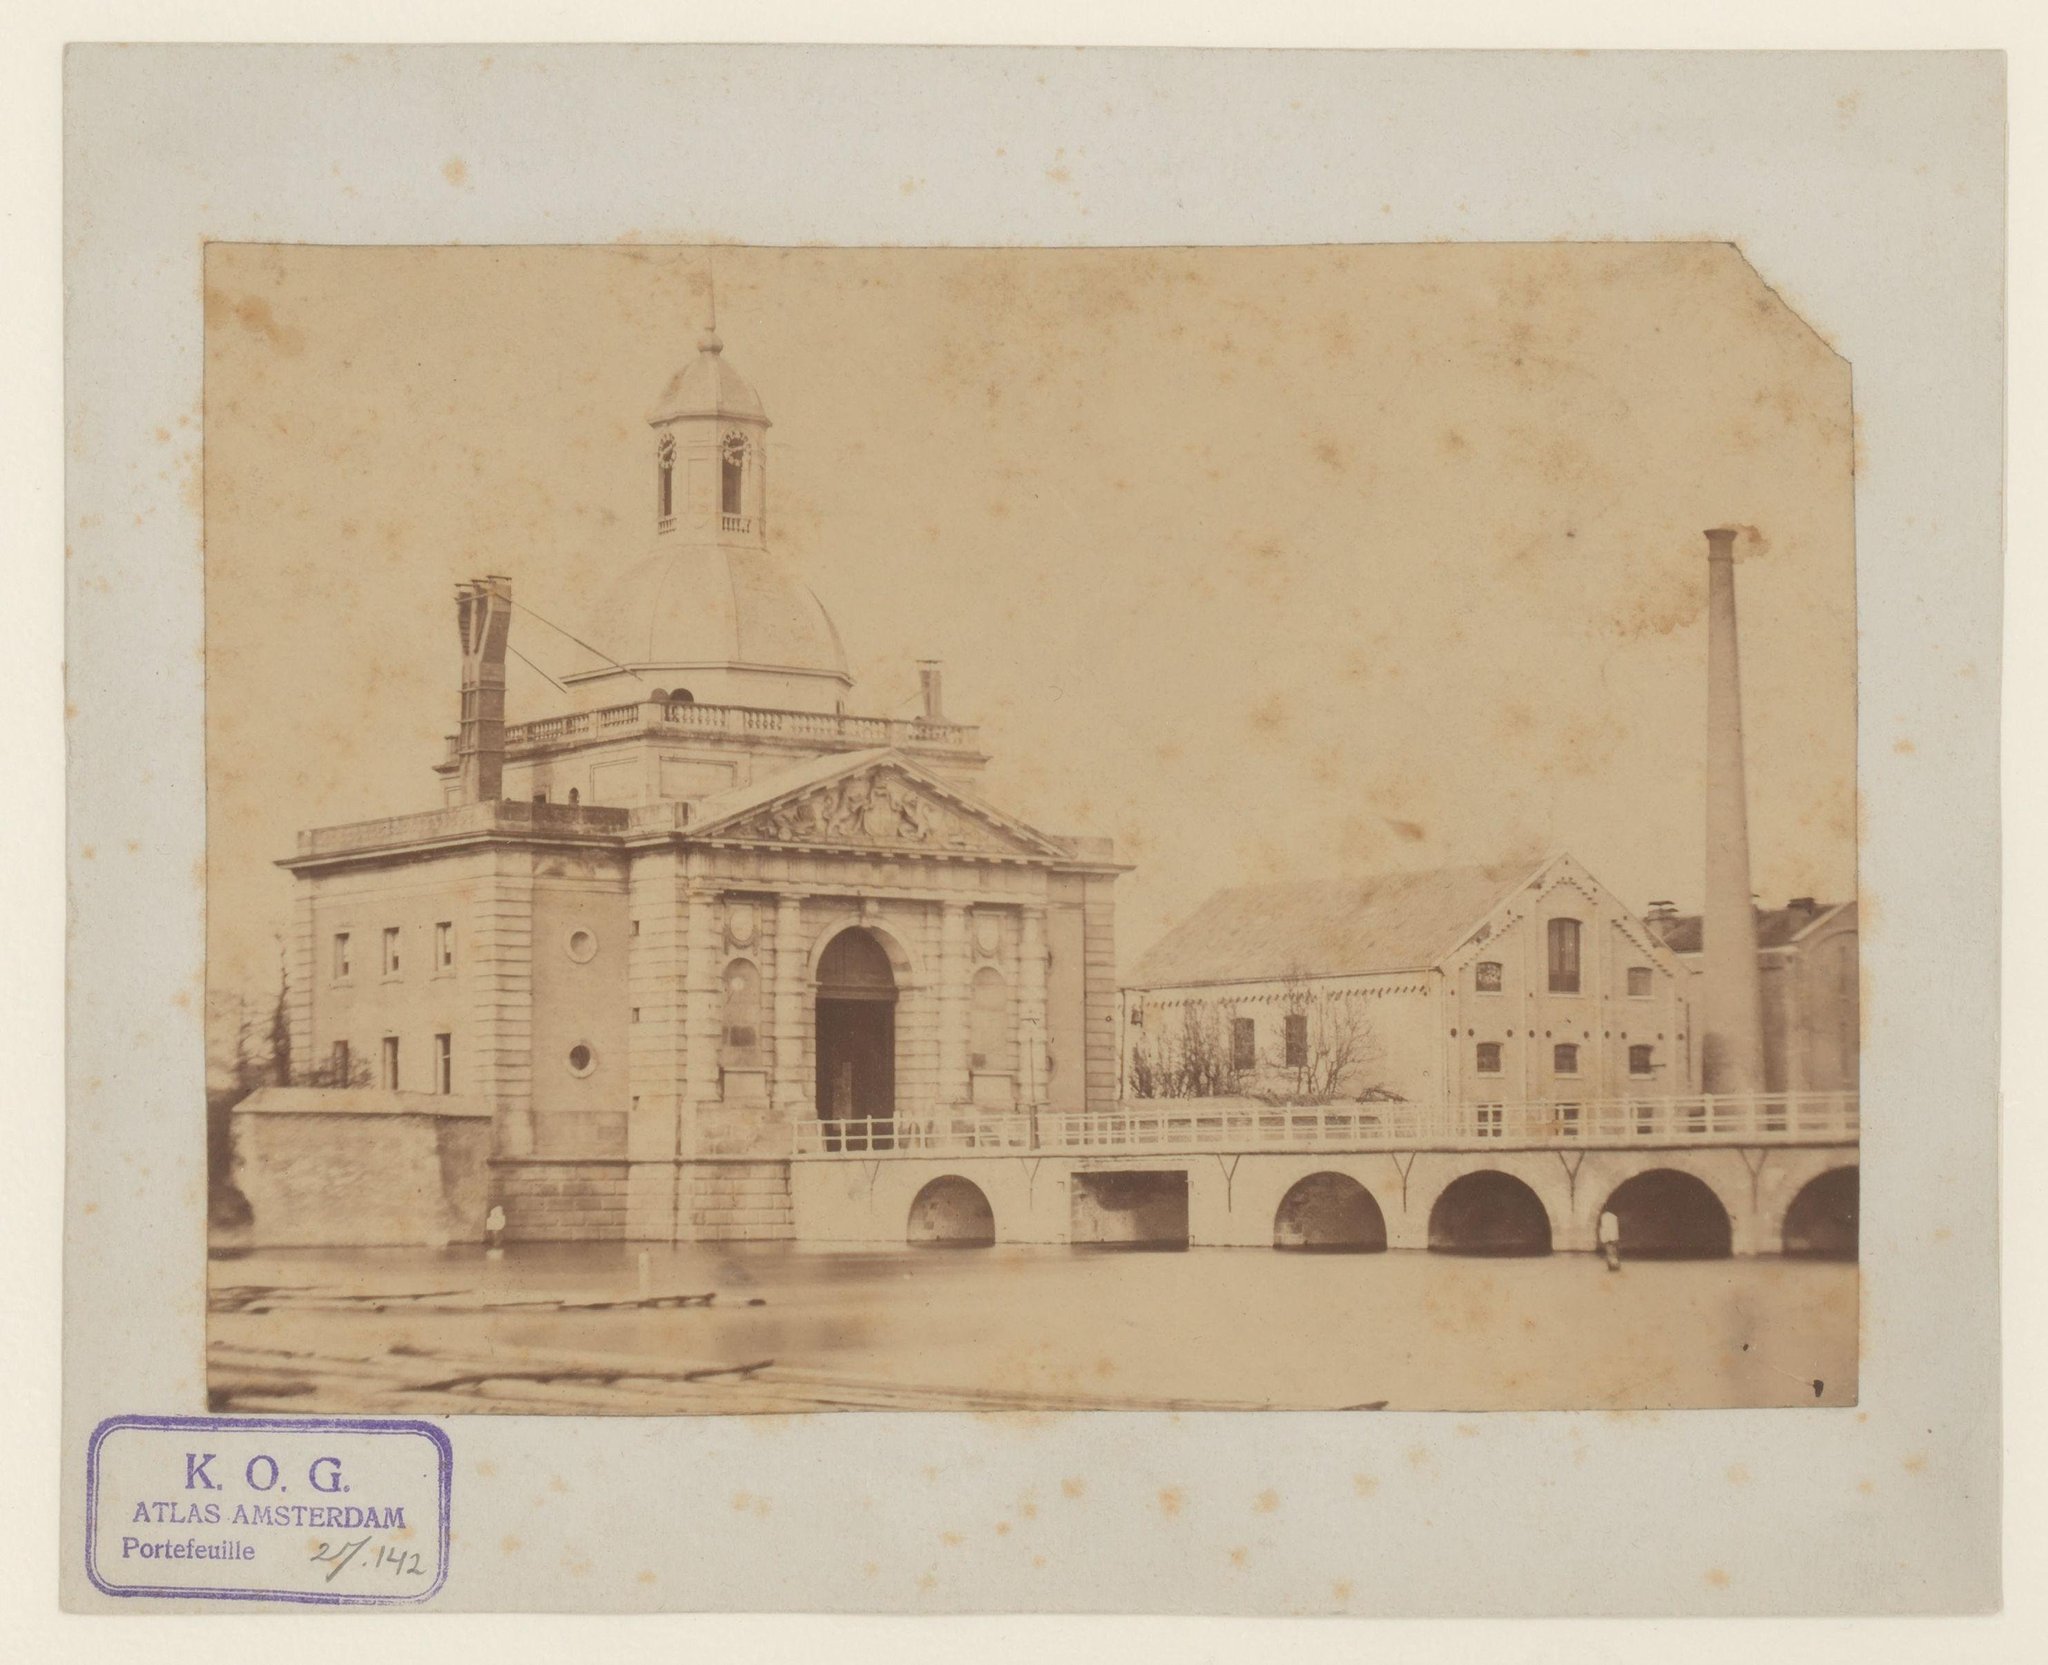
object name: photograph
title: Gezicht op de Tweede Muiderpoort te Amsterdam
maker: Anonymous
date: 1860-1900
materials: paper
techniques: albumen print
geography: amsterdam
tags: city-gate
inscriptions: collector's mark: Lugt 1641b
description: Onderwerpsrubriek binnen de Atlas Amsterdam: Poorten, verzamelbladen, J. Tweede Muiderpoort.